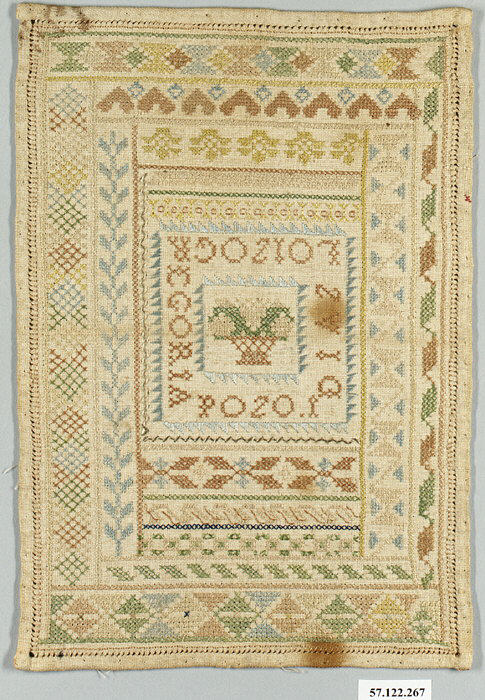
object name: sampler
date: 1801-1900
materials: linen, silk